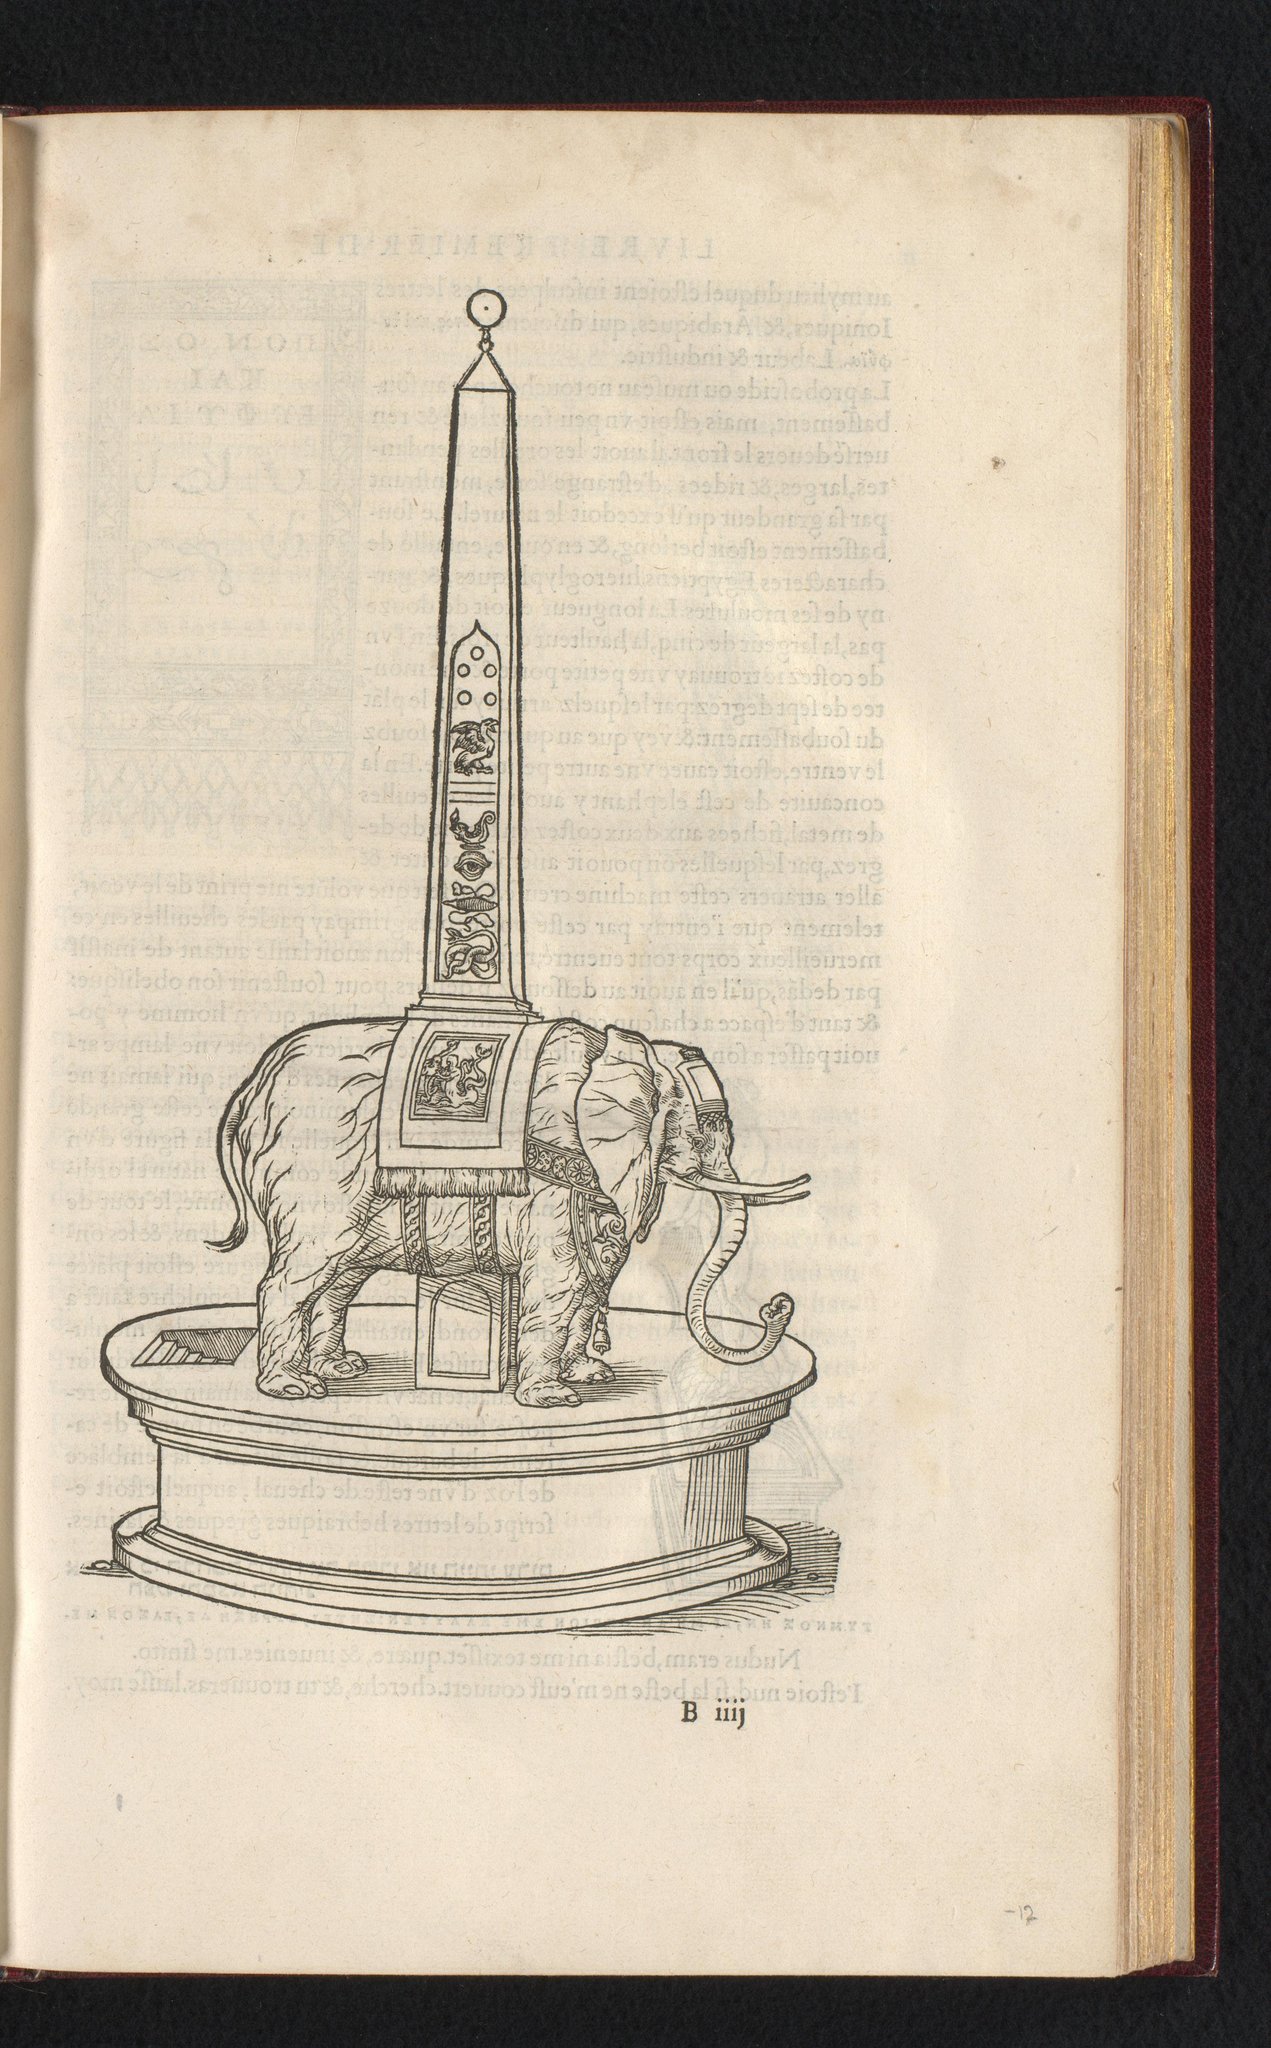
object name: book illustration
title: Standbeeld van een obelisk op de rug van een olifant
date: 1546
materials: paper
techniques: letterpress printing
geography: paris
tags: obelisk, needle, (scenes from) specific works of literature: colonna, hypnerotomachia poliphili, pedestal of a piece of sculpture (perhaps in the form of a herm), trunked animals: elephant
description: Prent uit: Colonna, Francesco. Hypnerotomachie ou discours du songe de Poliphile, deduisant comme amour le combat a l'occasion de Polia. Parijs: Jacques Kerver, 1546, recto fol. 10.